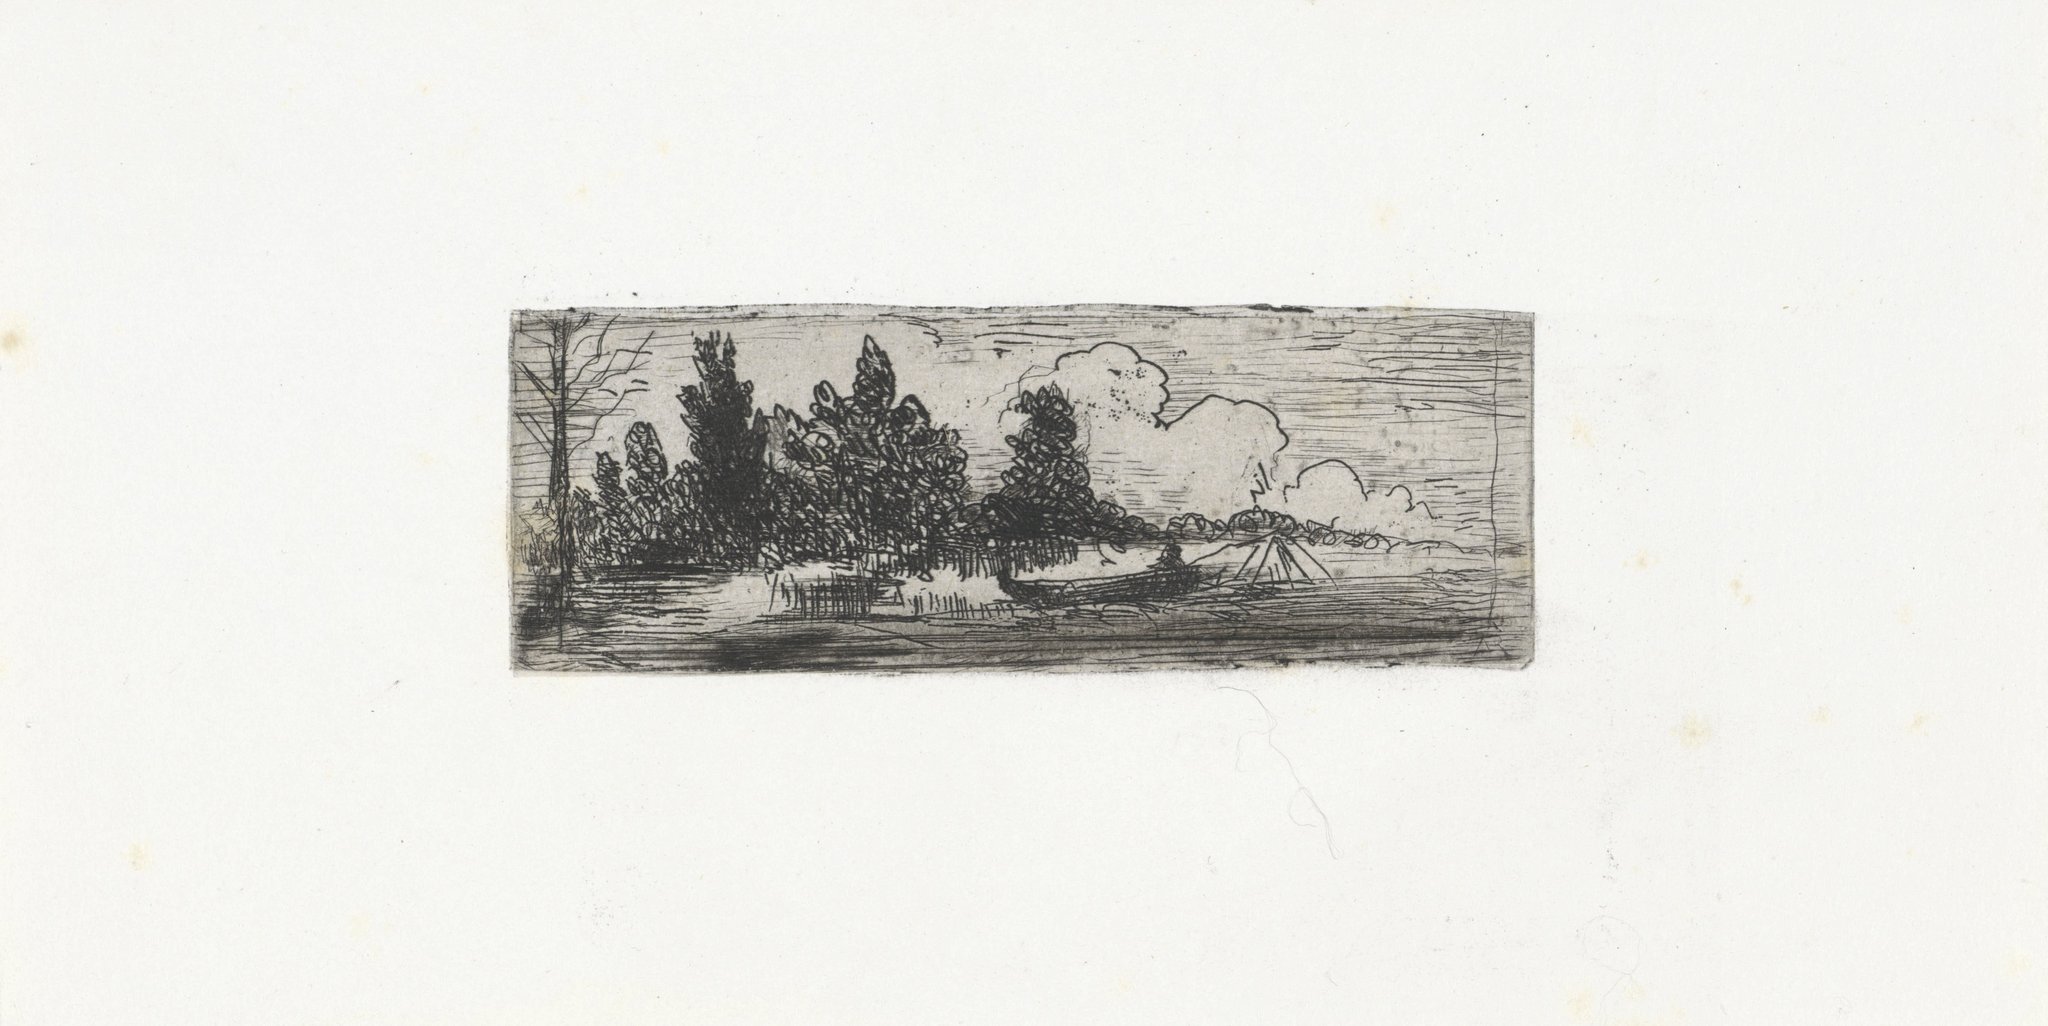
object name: print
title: Rivierlandschap met een boot, en een kale boom links op de voorgrond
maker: arnoud schaepkens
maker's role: print maker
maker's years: 1816-1904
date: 1831-1904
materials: paper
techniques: drypoint, etching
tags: river, rowing-boat, canoe, etc.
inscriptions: collector's mark: Lugt 2228